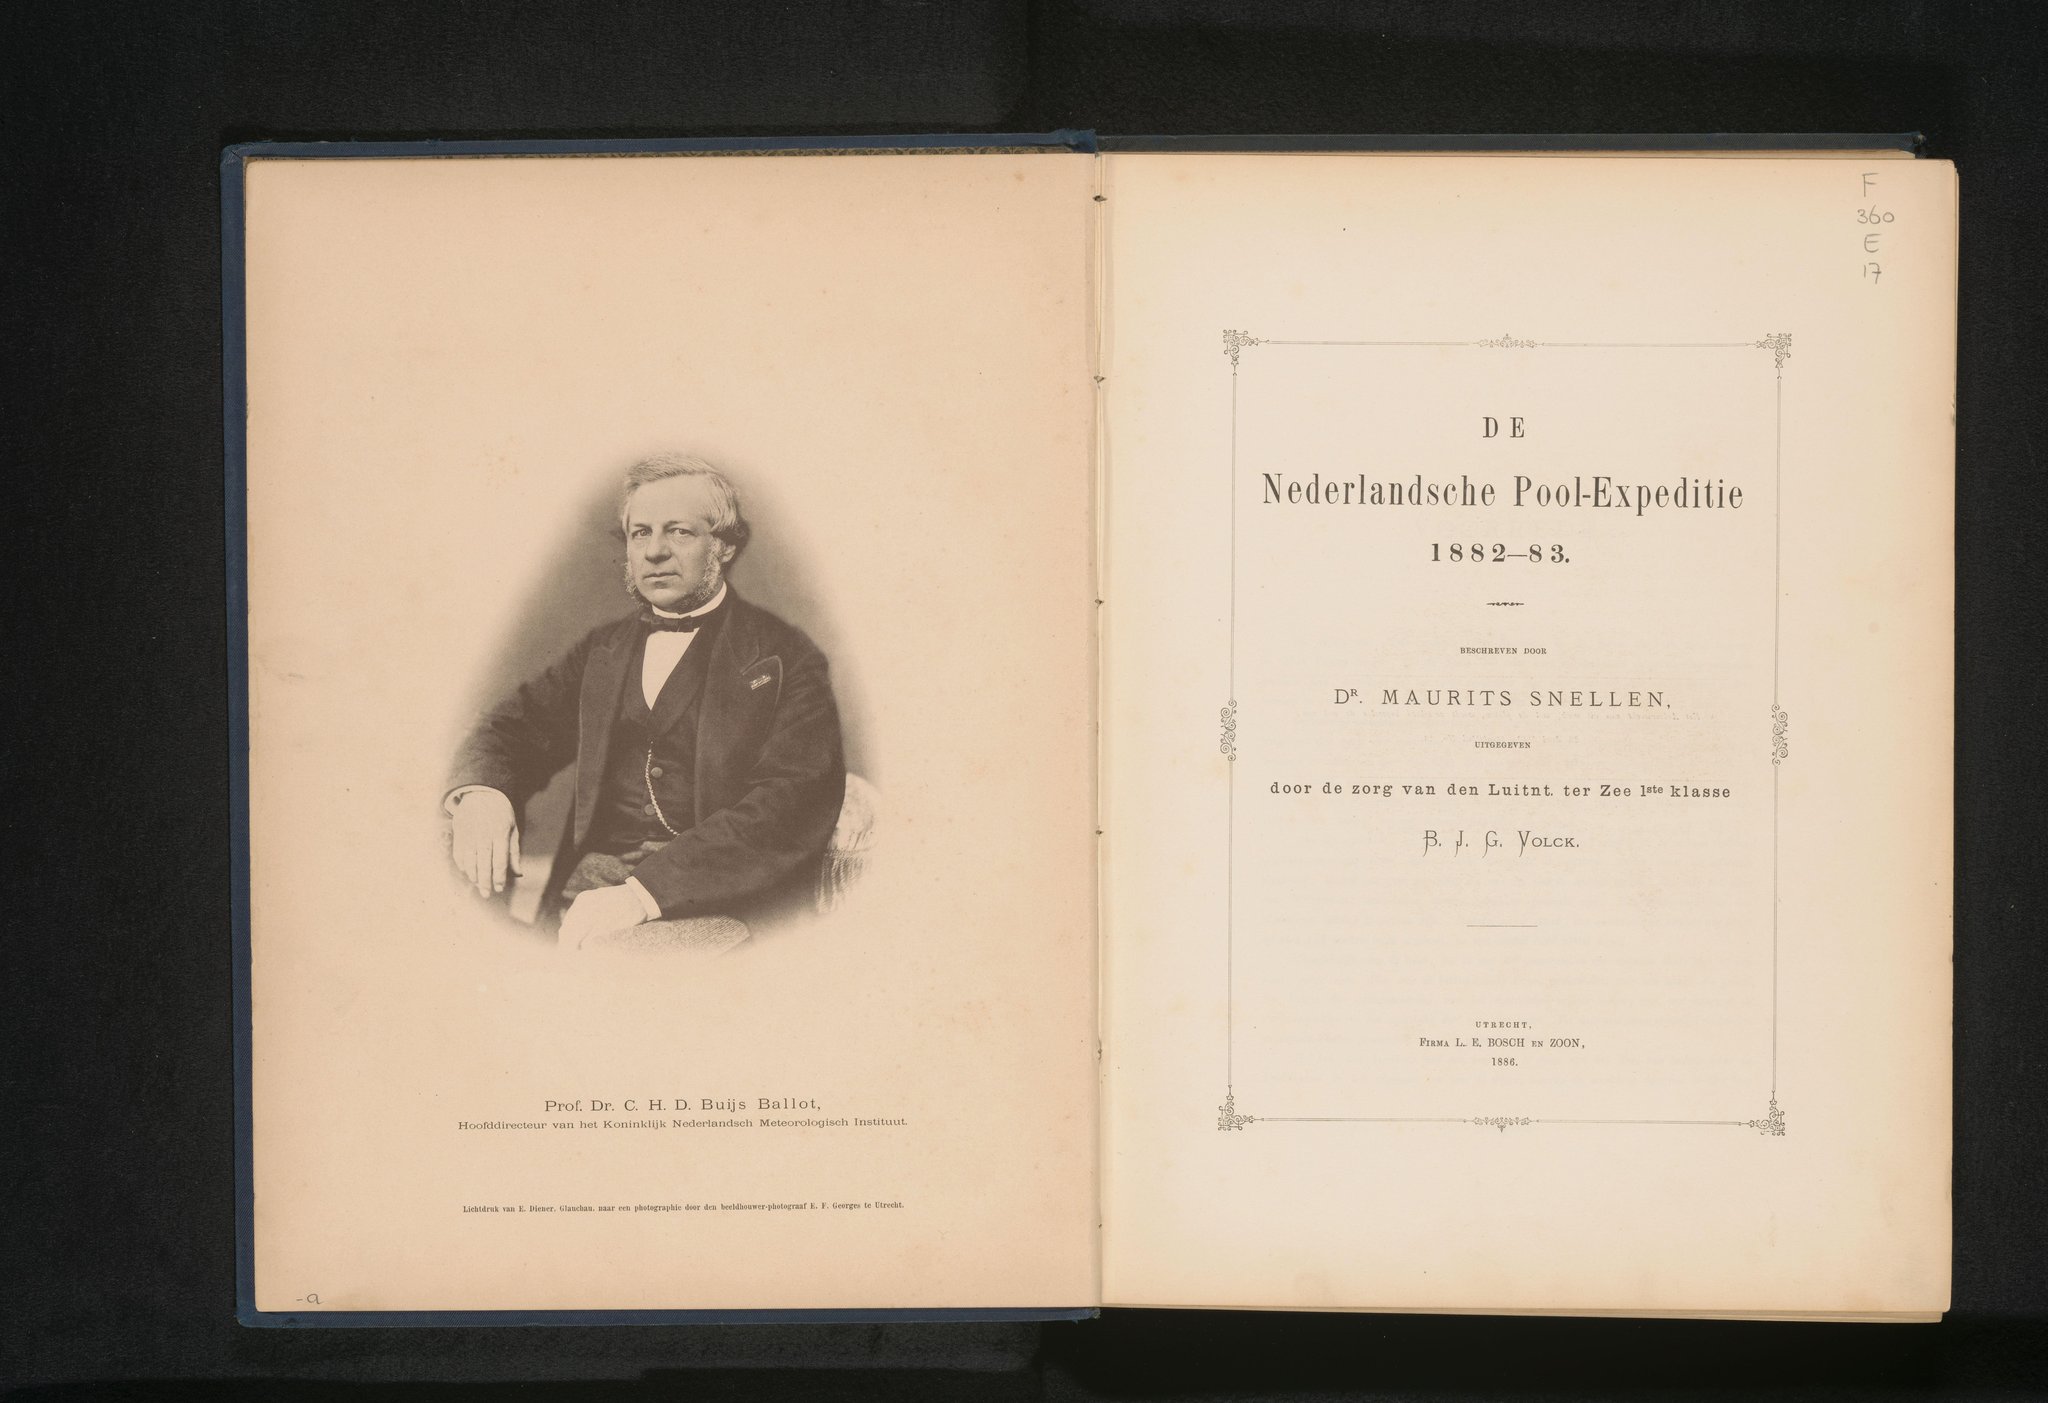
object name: page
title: Prof. Dr. C. H. D. Buijs Ballot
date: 1881-1886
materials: paper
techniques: photograph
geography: glauchau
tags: utrecht, physicist, historical persons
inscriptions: inscription: ‘Hoofddirecteur van het Koninklijk Nederlandsch Meteorologisch Instituut’